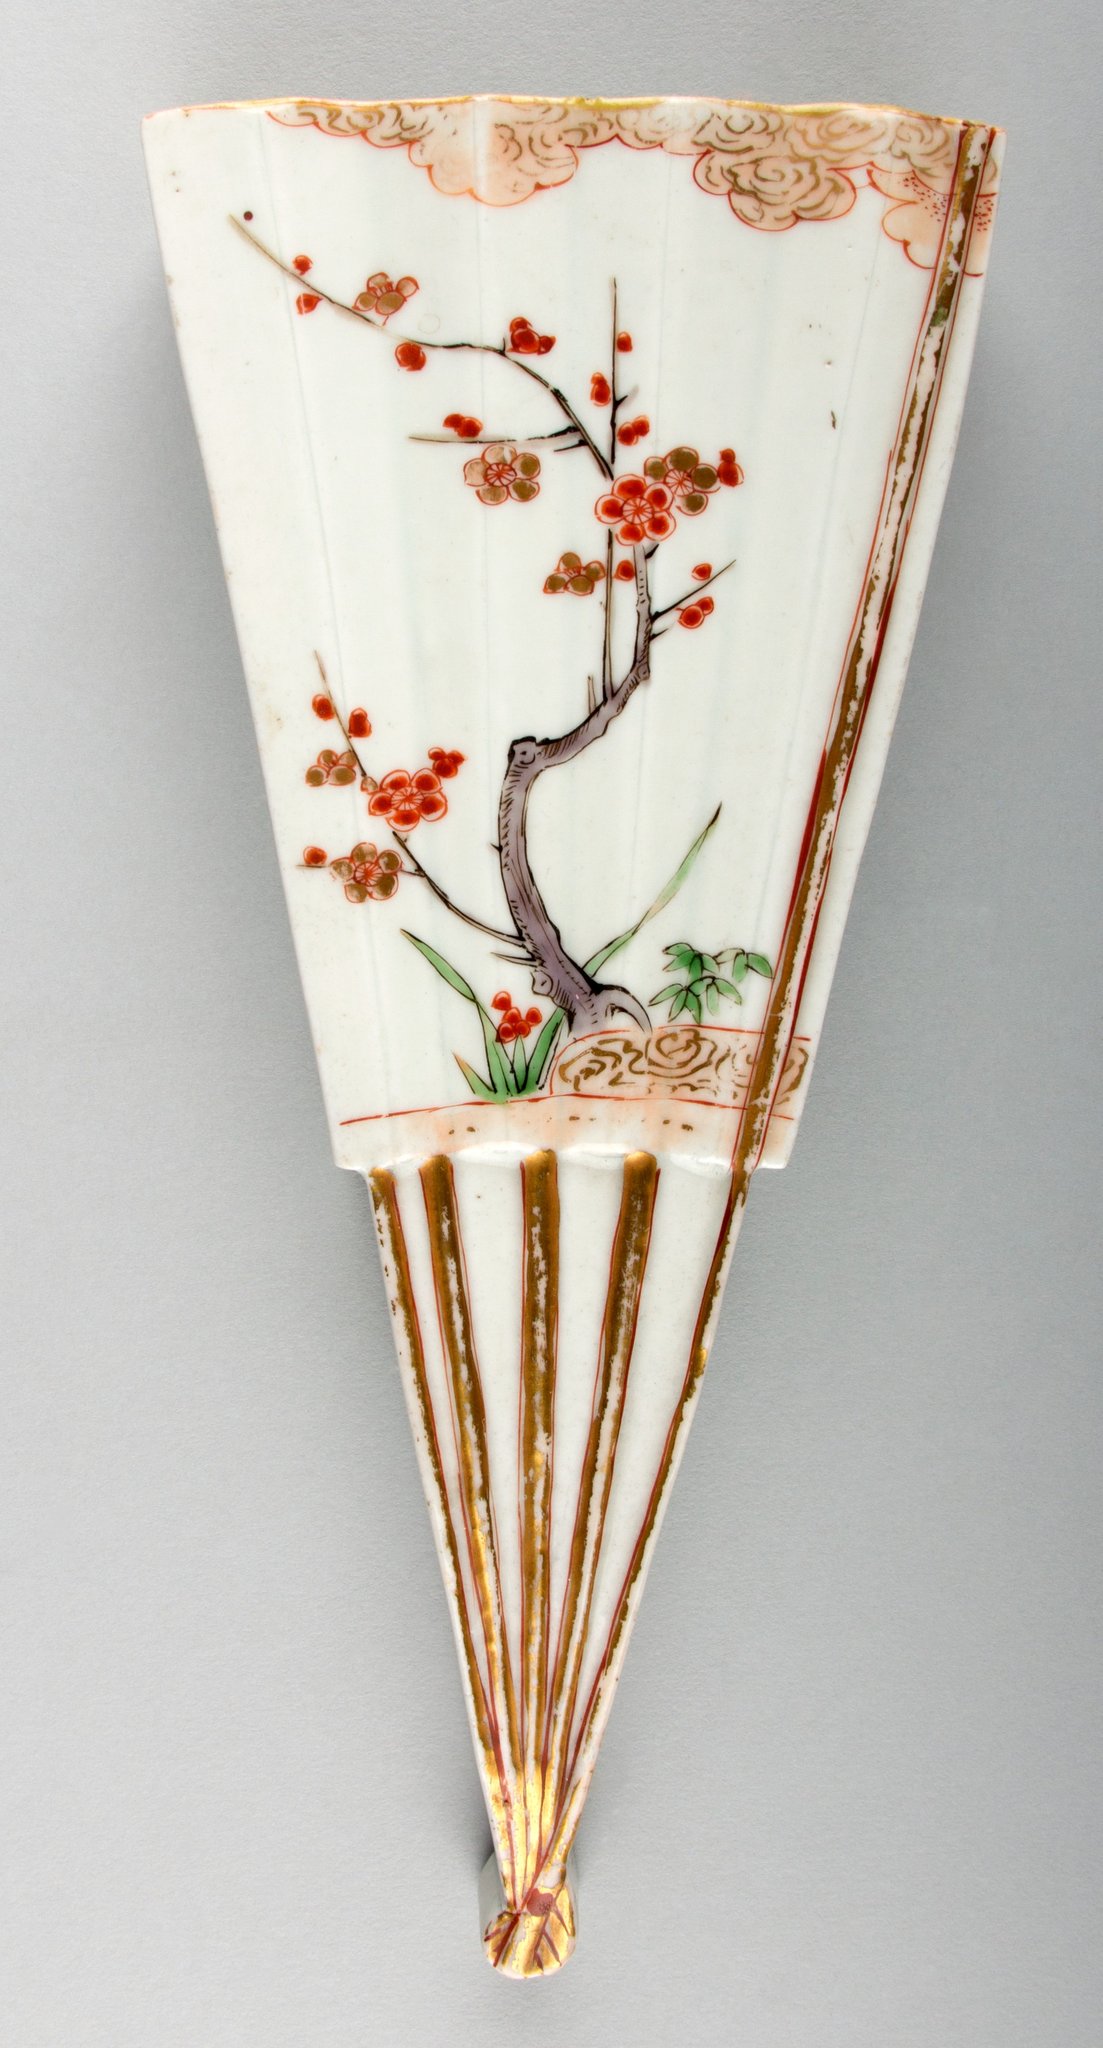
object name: wall vase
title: One of a Pair of Fan-Shaped Hanging Wall Vases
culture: japanese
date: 1667-1700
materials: enamel, gold, porcelain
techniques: overglaze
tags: flowers,trees